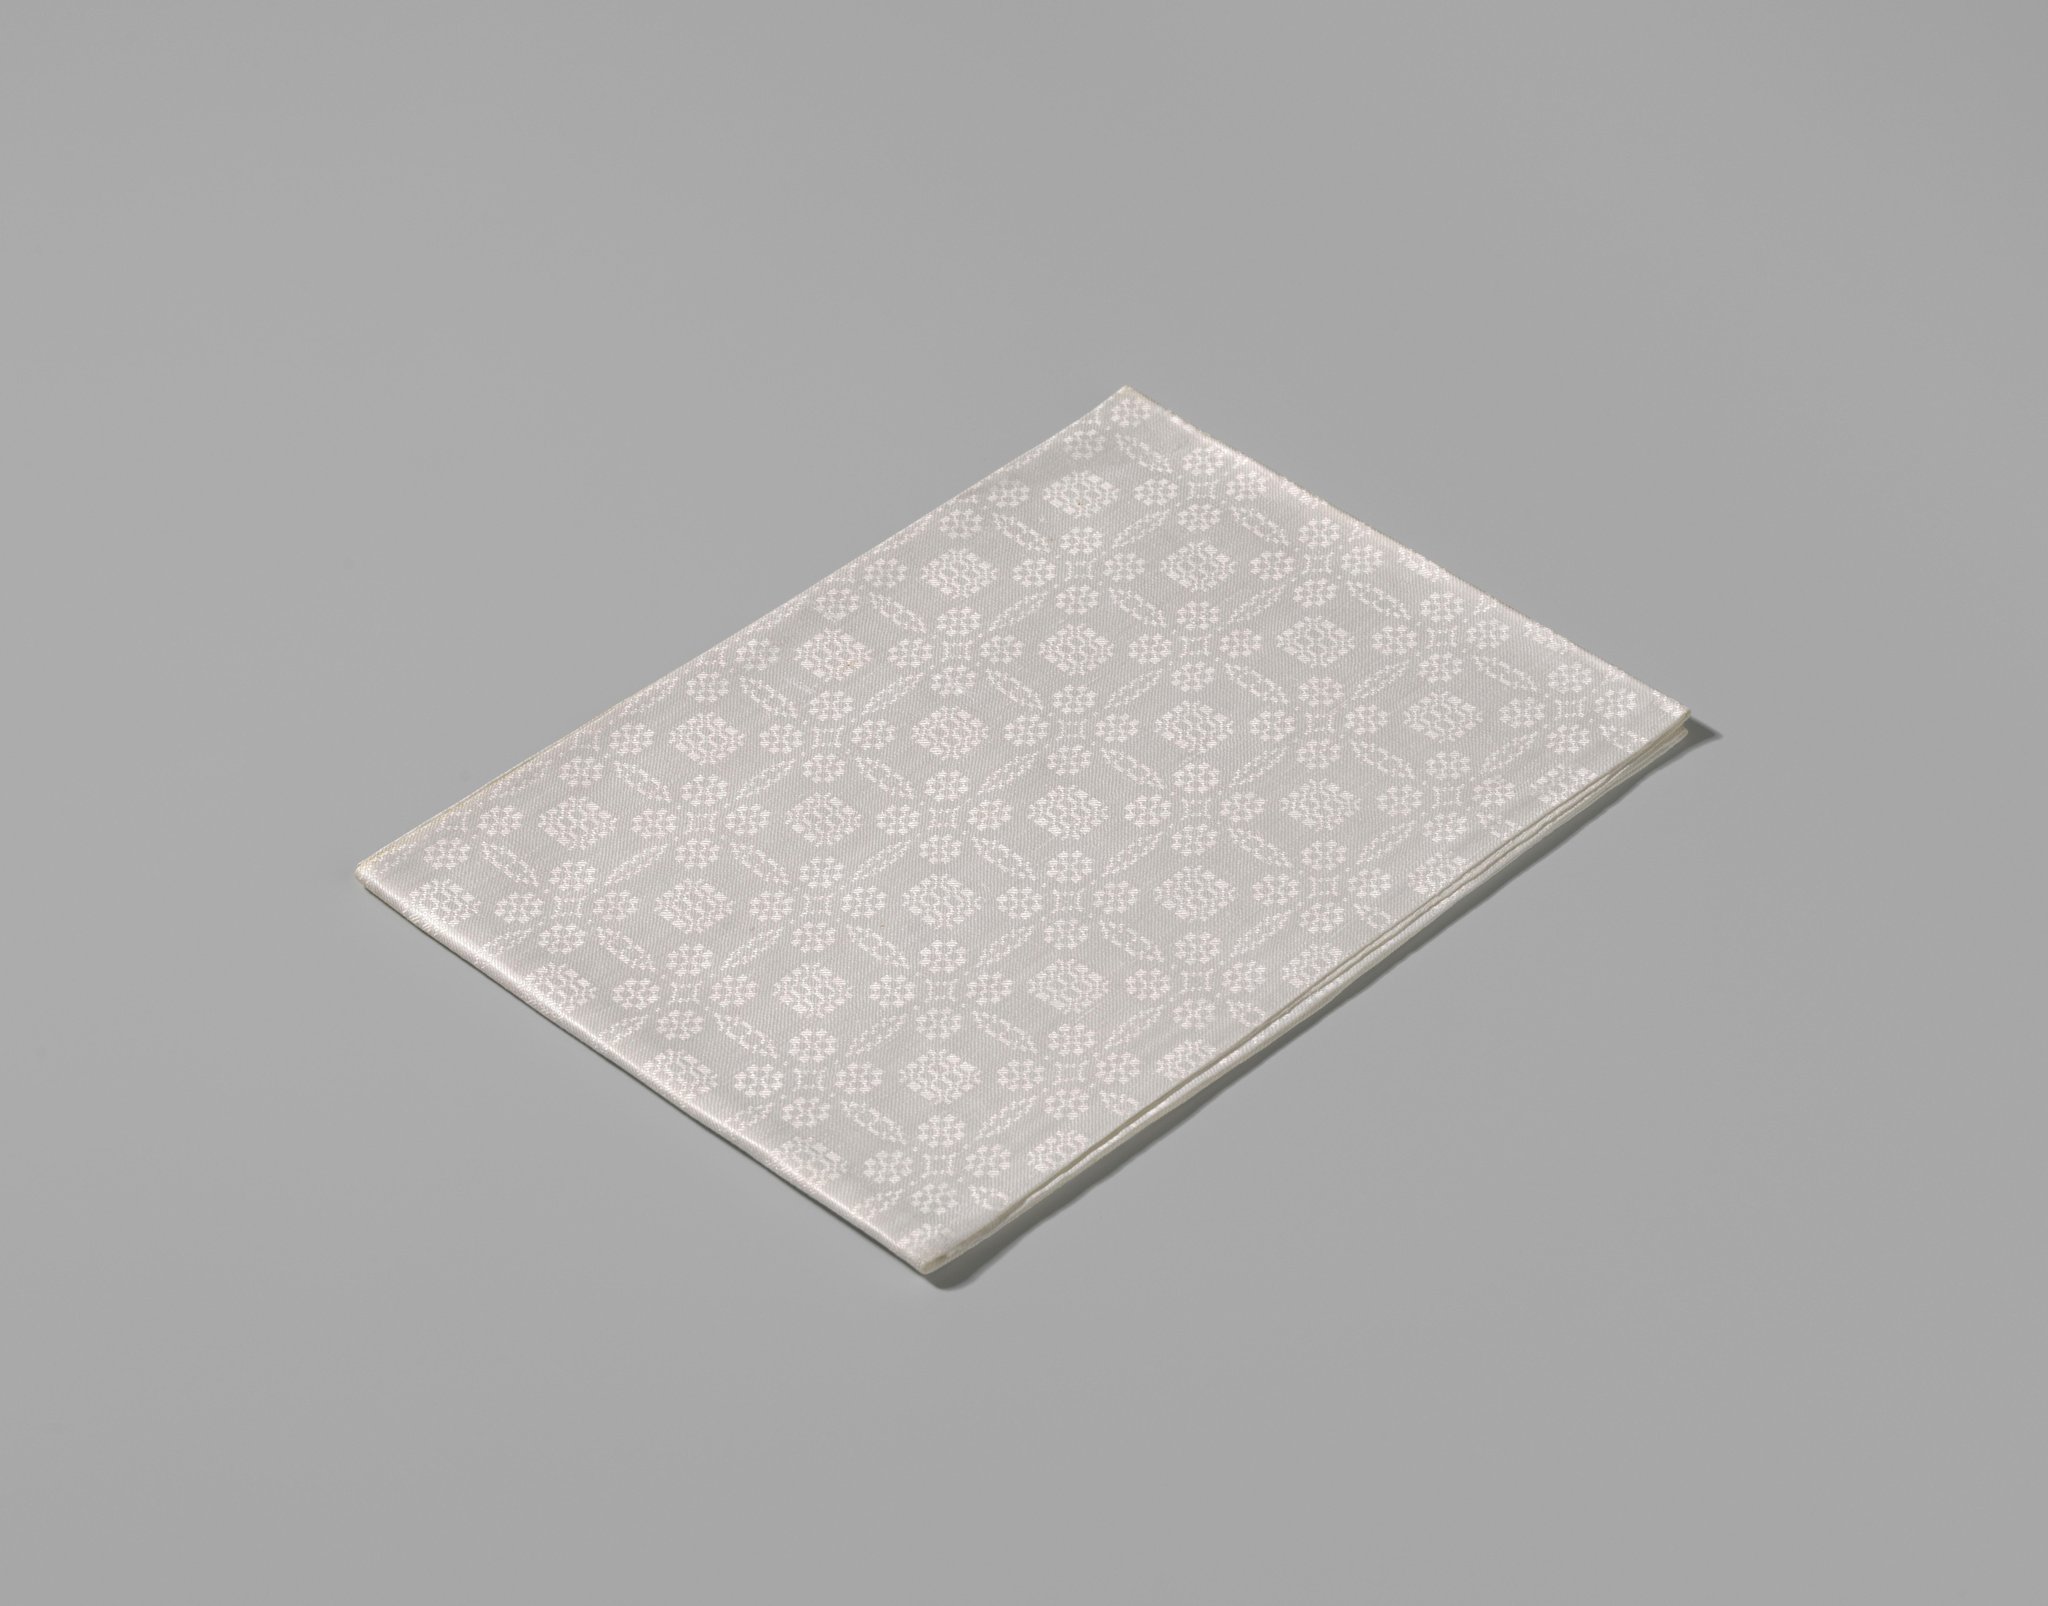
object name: napkin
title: Servet van wit linnen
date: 1650-1675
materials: linen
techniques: peeled fabric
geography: northern netherlands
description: Wit linnen servet, pellen in keperbinding, gemerkt kroon RR WO 40 en 6.